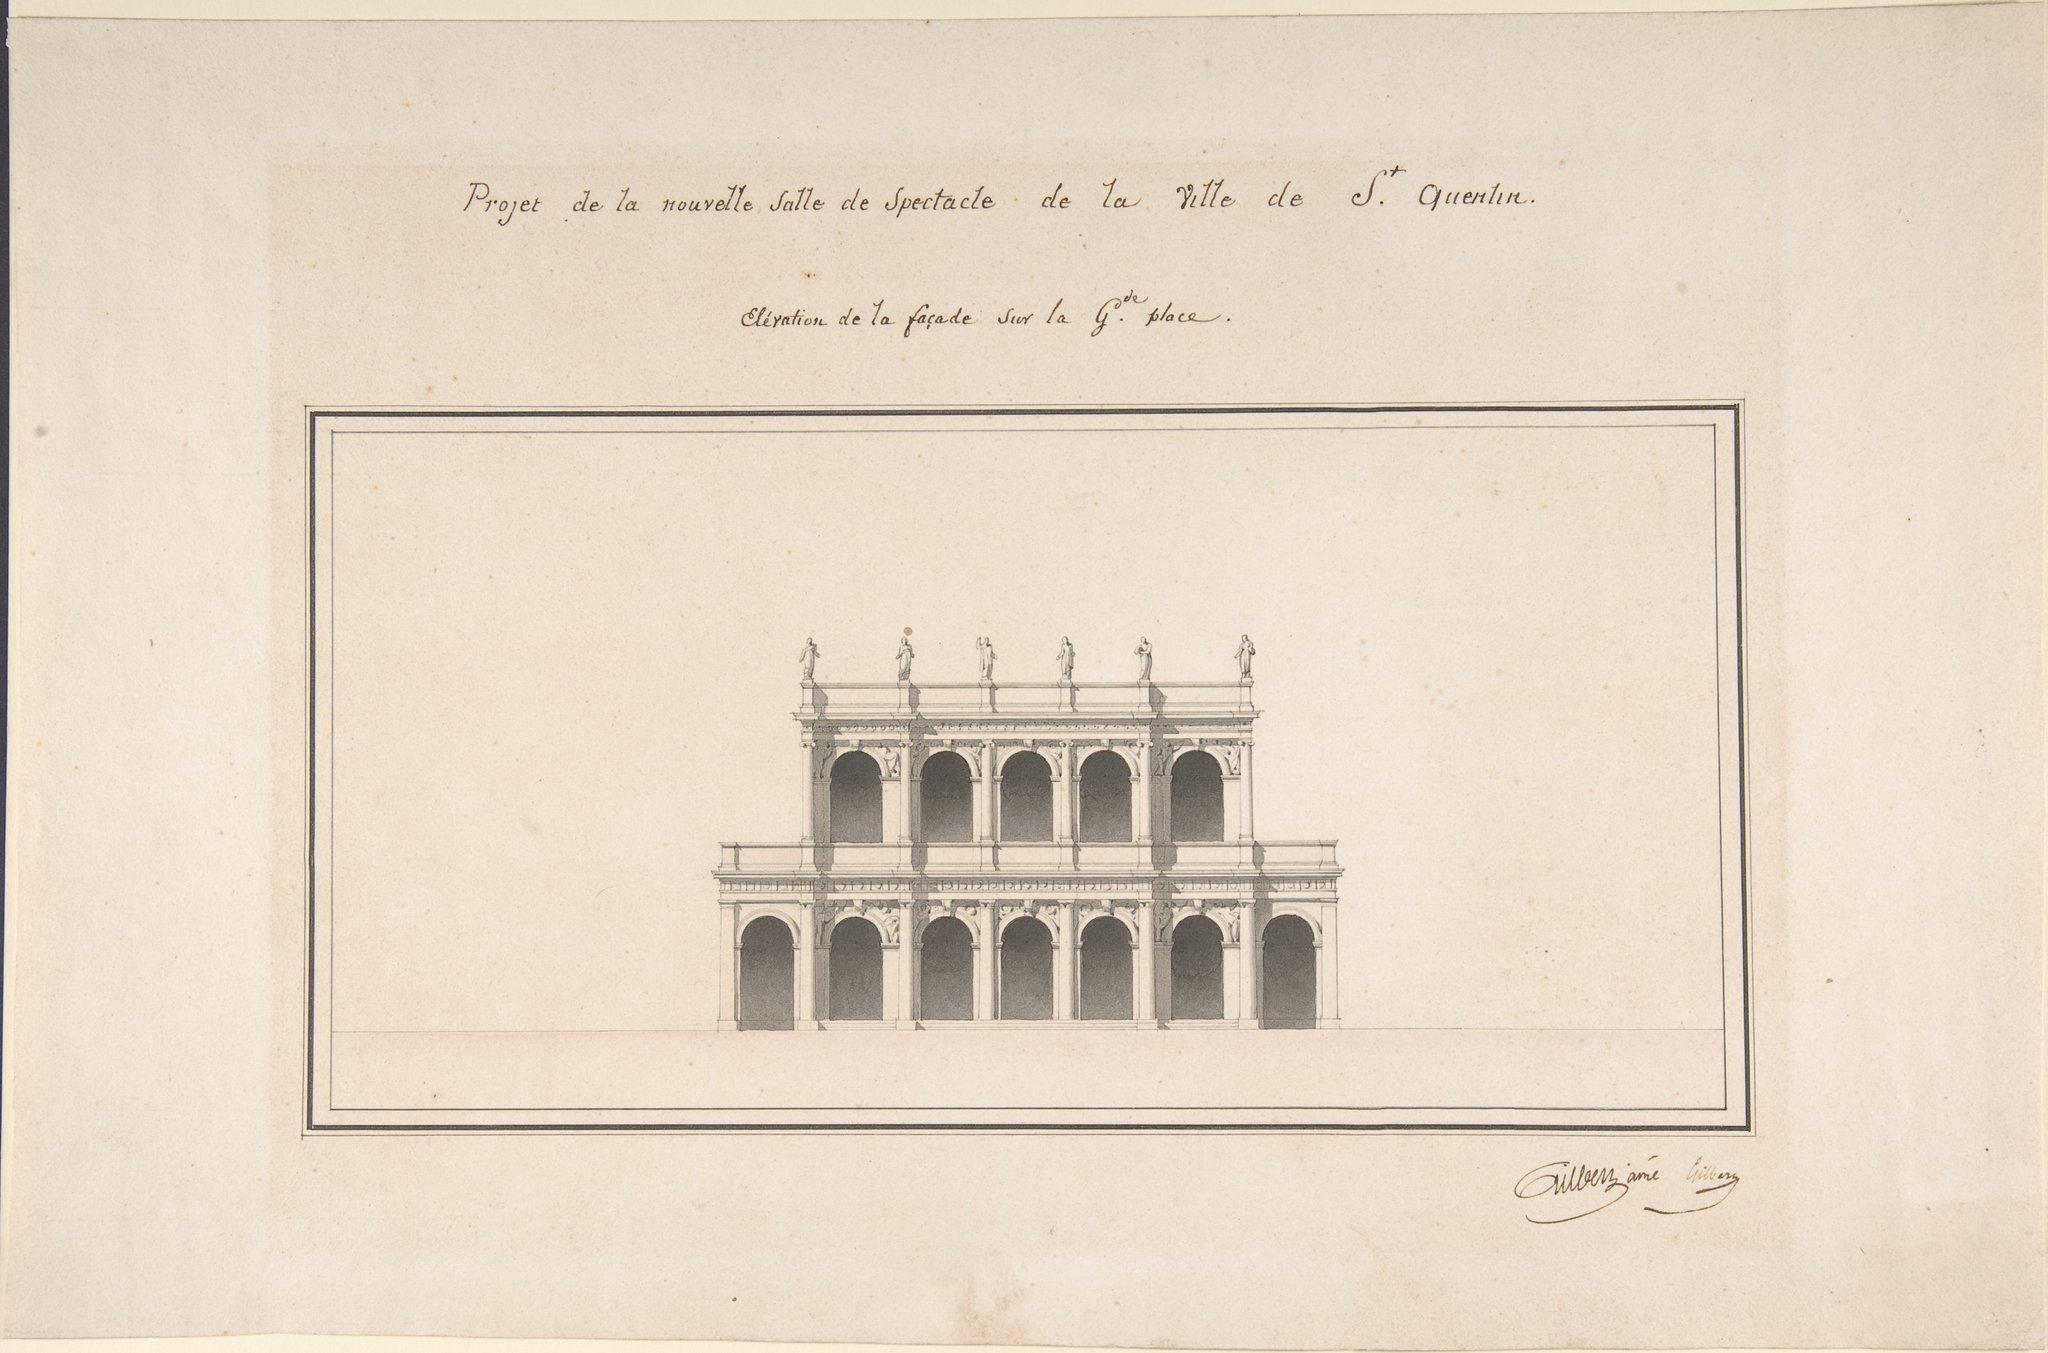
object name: drawing ornament architecture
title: Project for the New Theater at St. Quentin (Aisne) - Elevation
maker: emile-jacques gilbert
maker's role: architect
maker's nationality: french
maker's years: 1793-1874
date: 1841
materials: pencil, watercolor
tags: architecture,buildings